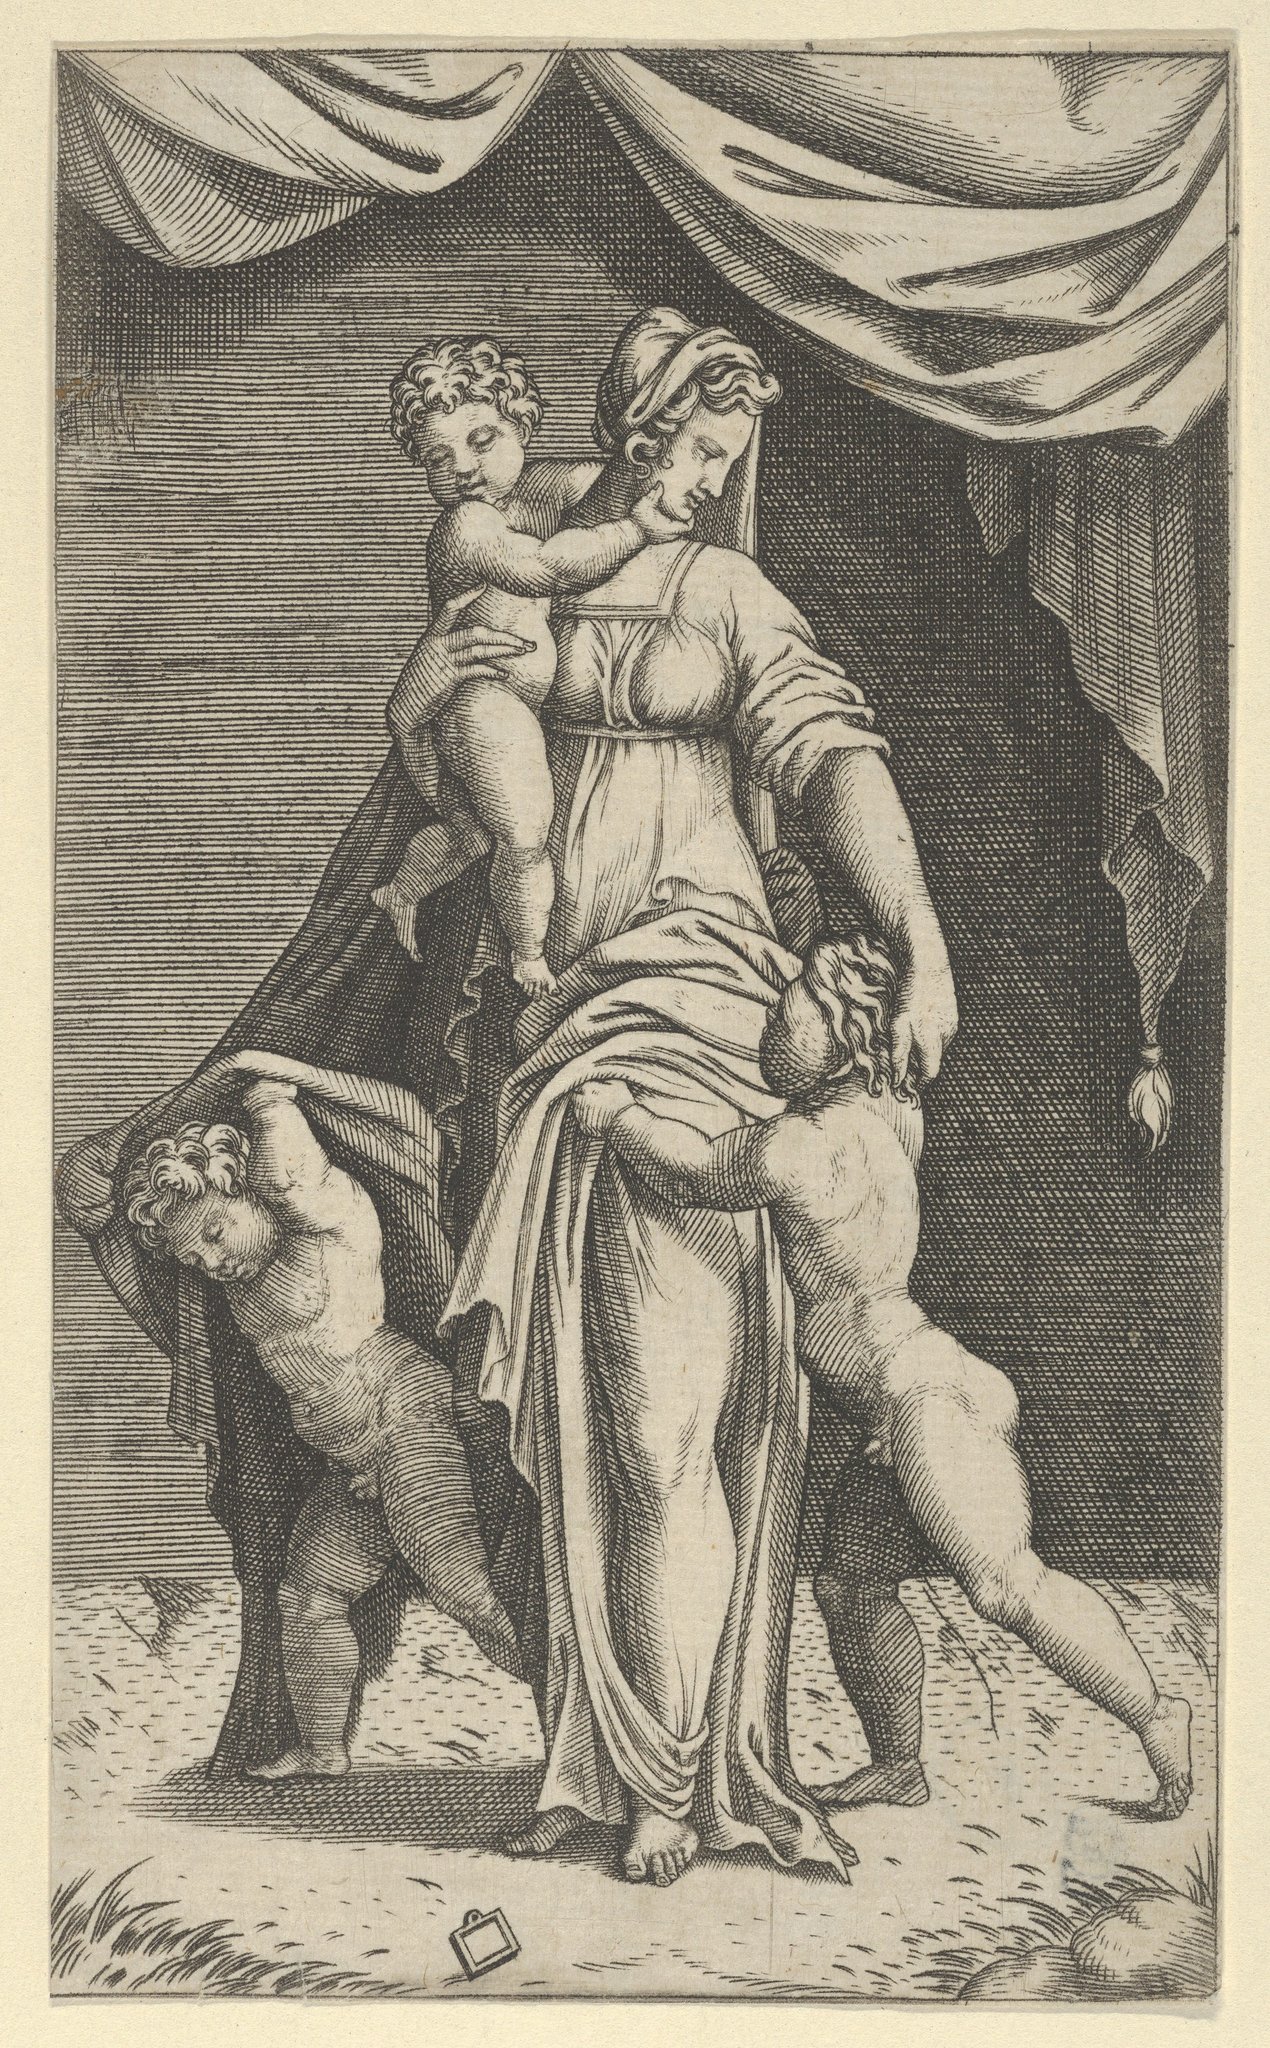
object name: print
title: Charity personified by a woman with three children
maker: Anonymous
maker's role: artist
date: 1520-1540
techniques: engraving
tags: children,women